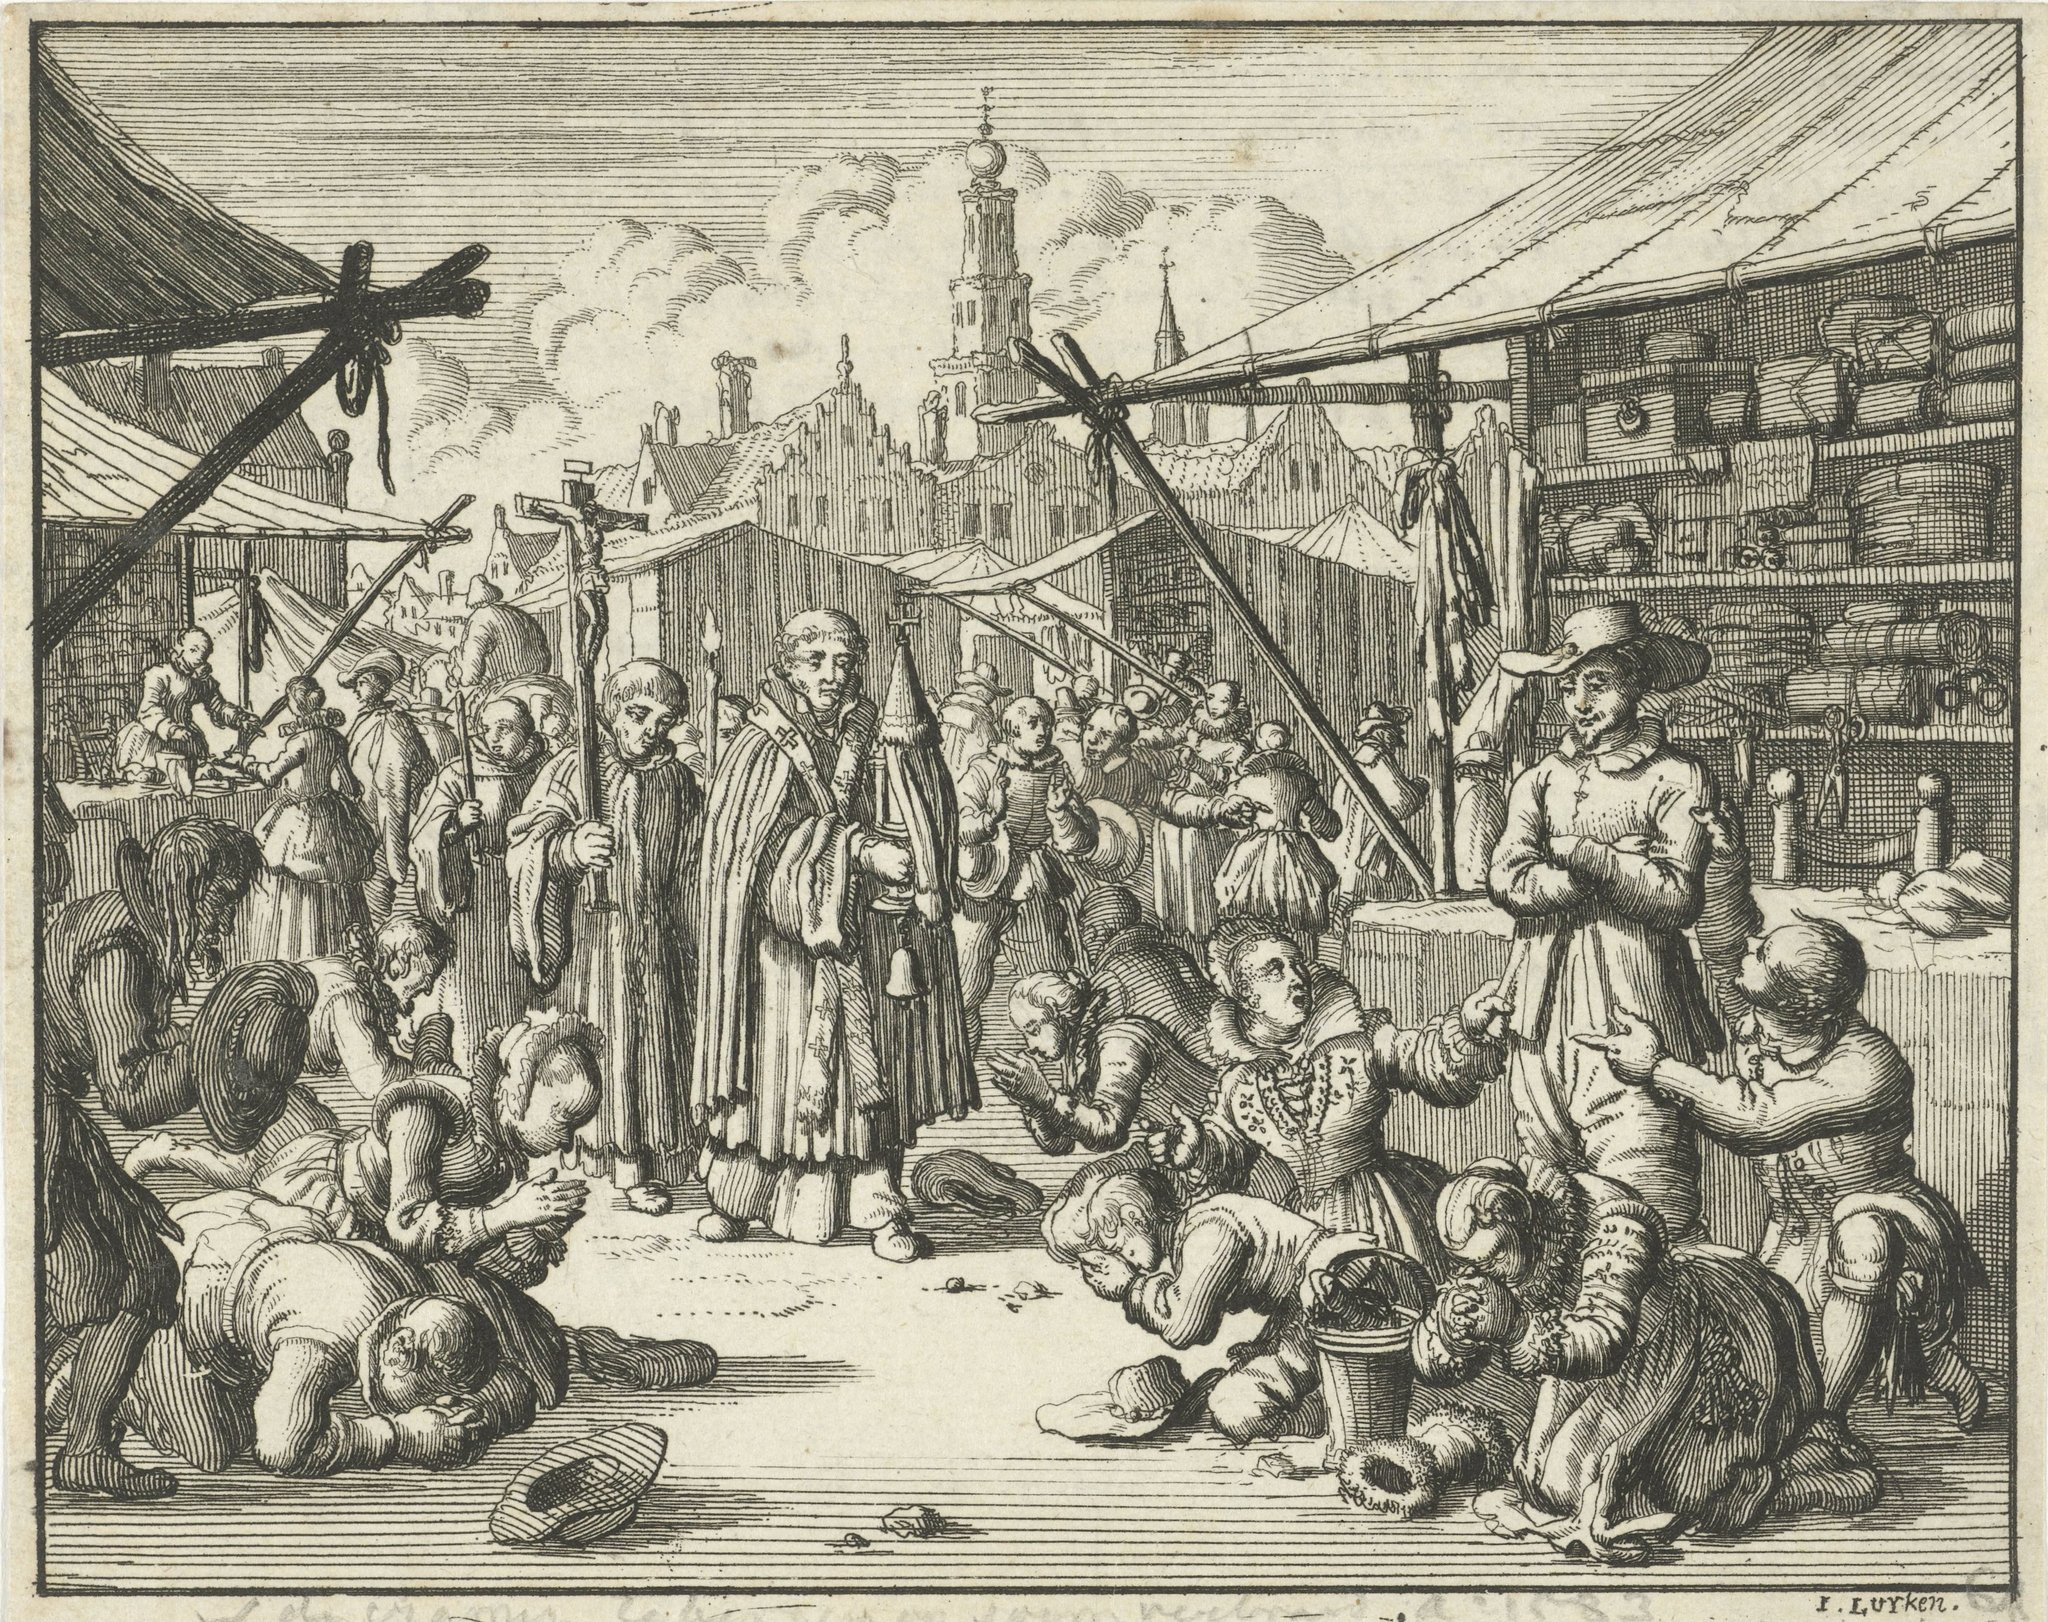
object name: book illustration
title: Simon de Kramer weigert te Bergen op Zoom voor een processie te knielen, 1553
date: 1685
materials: paper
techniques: etching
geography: amsterdam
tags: procession ~ christian religion, kneeling on both knees, bergen op zoom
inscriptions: number: ‘64’, inscription: ‘Omtrent het [...] ander Schrijver’, inscription: ‘S de [...] Ao 1553’, collector's mark: Lugt 2228